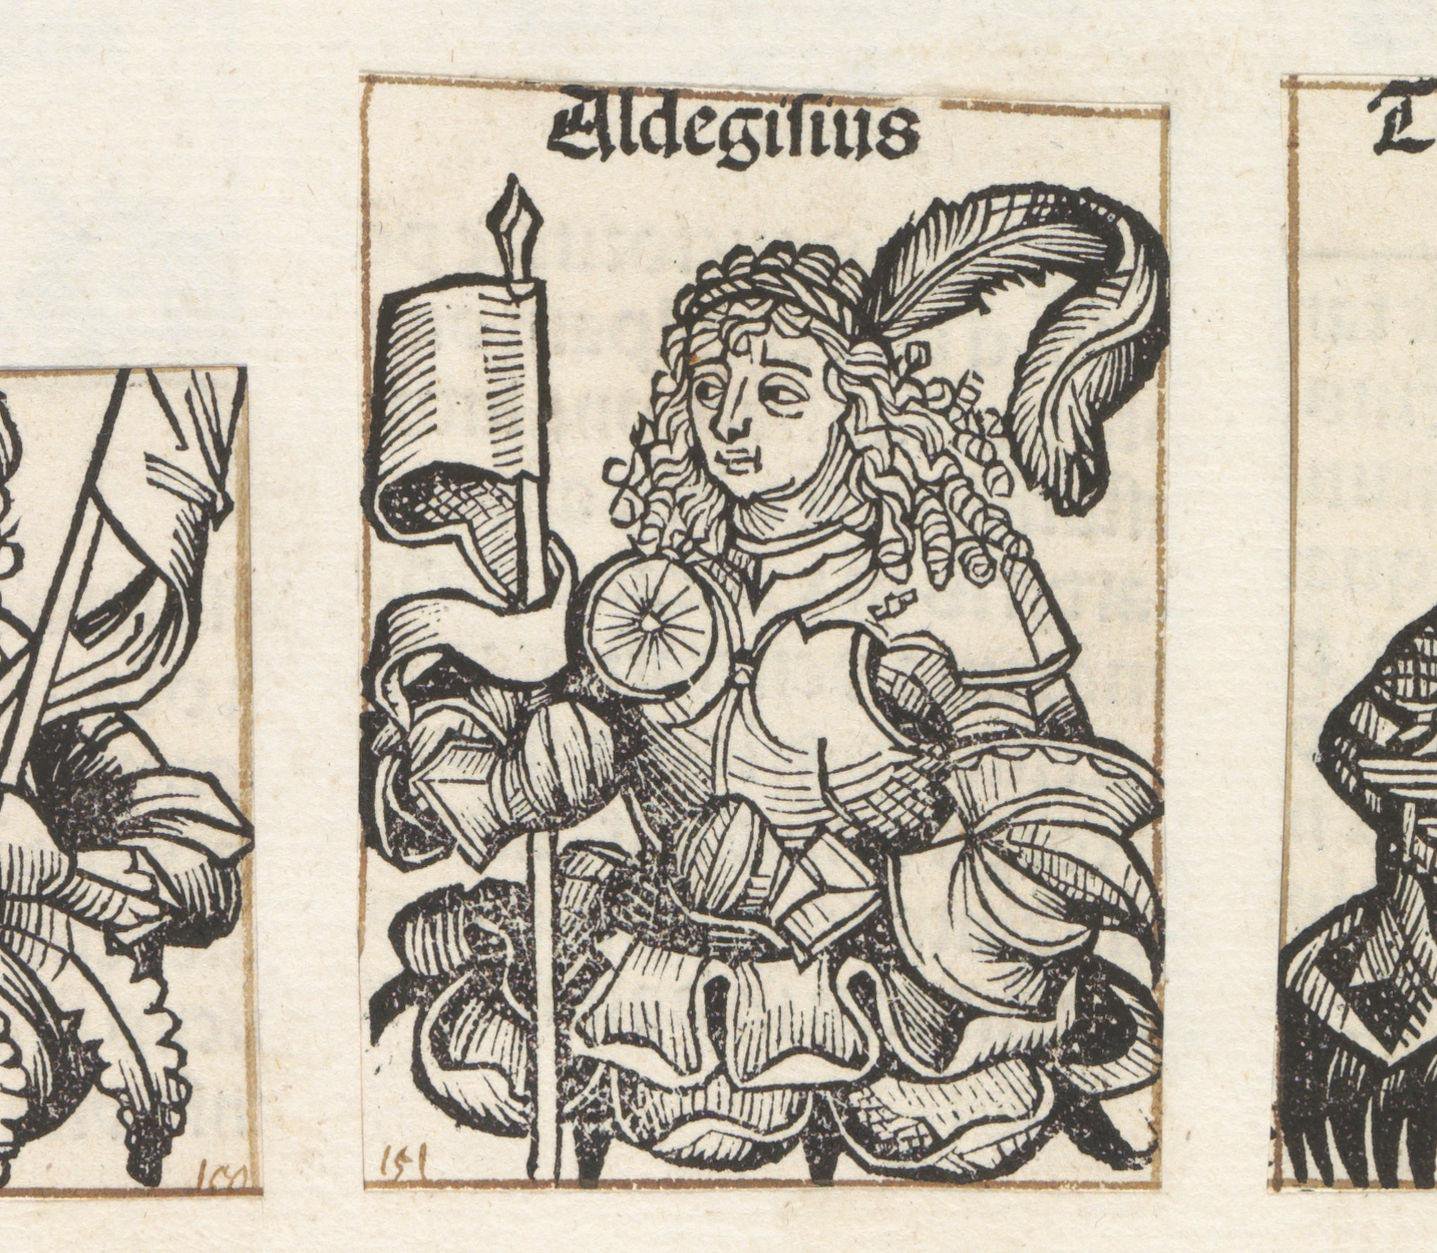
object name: book illustration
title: Prins Adalgis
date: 1493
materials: paper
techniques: letterpress printing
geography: nuremberg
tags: standard-bearer, flag-bearer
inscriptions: inscription: ‘151’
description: De houtsnede wordt herhaaldelijk gebruikt als boekillustratie in de Liber Chronicarum (of Neurenbergkroniek) van Hartmann Schedel, verschenen in het Latijn en Duits in 1493. Zie de Latijnse uitgave, folio 167r.